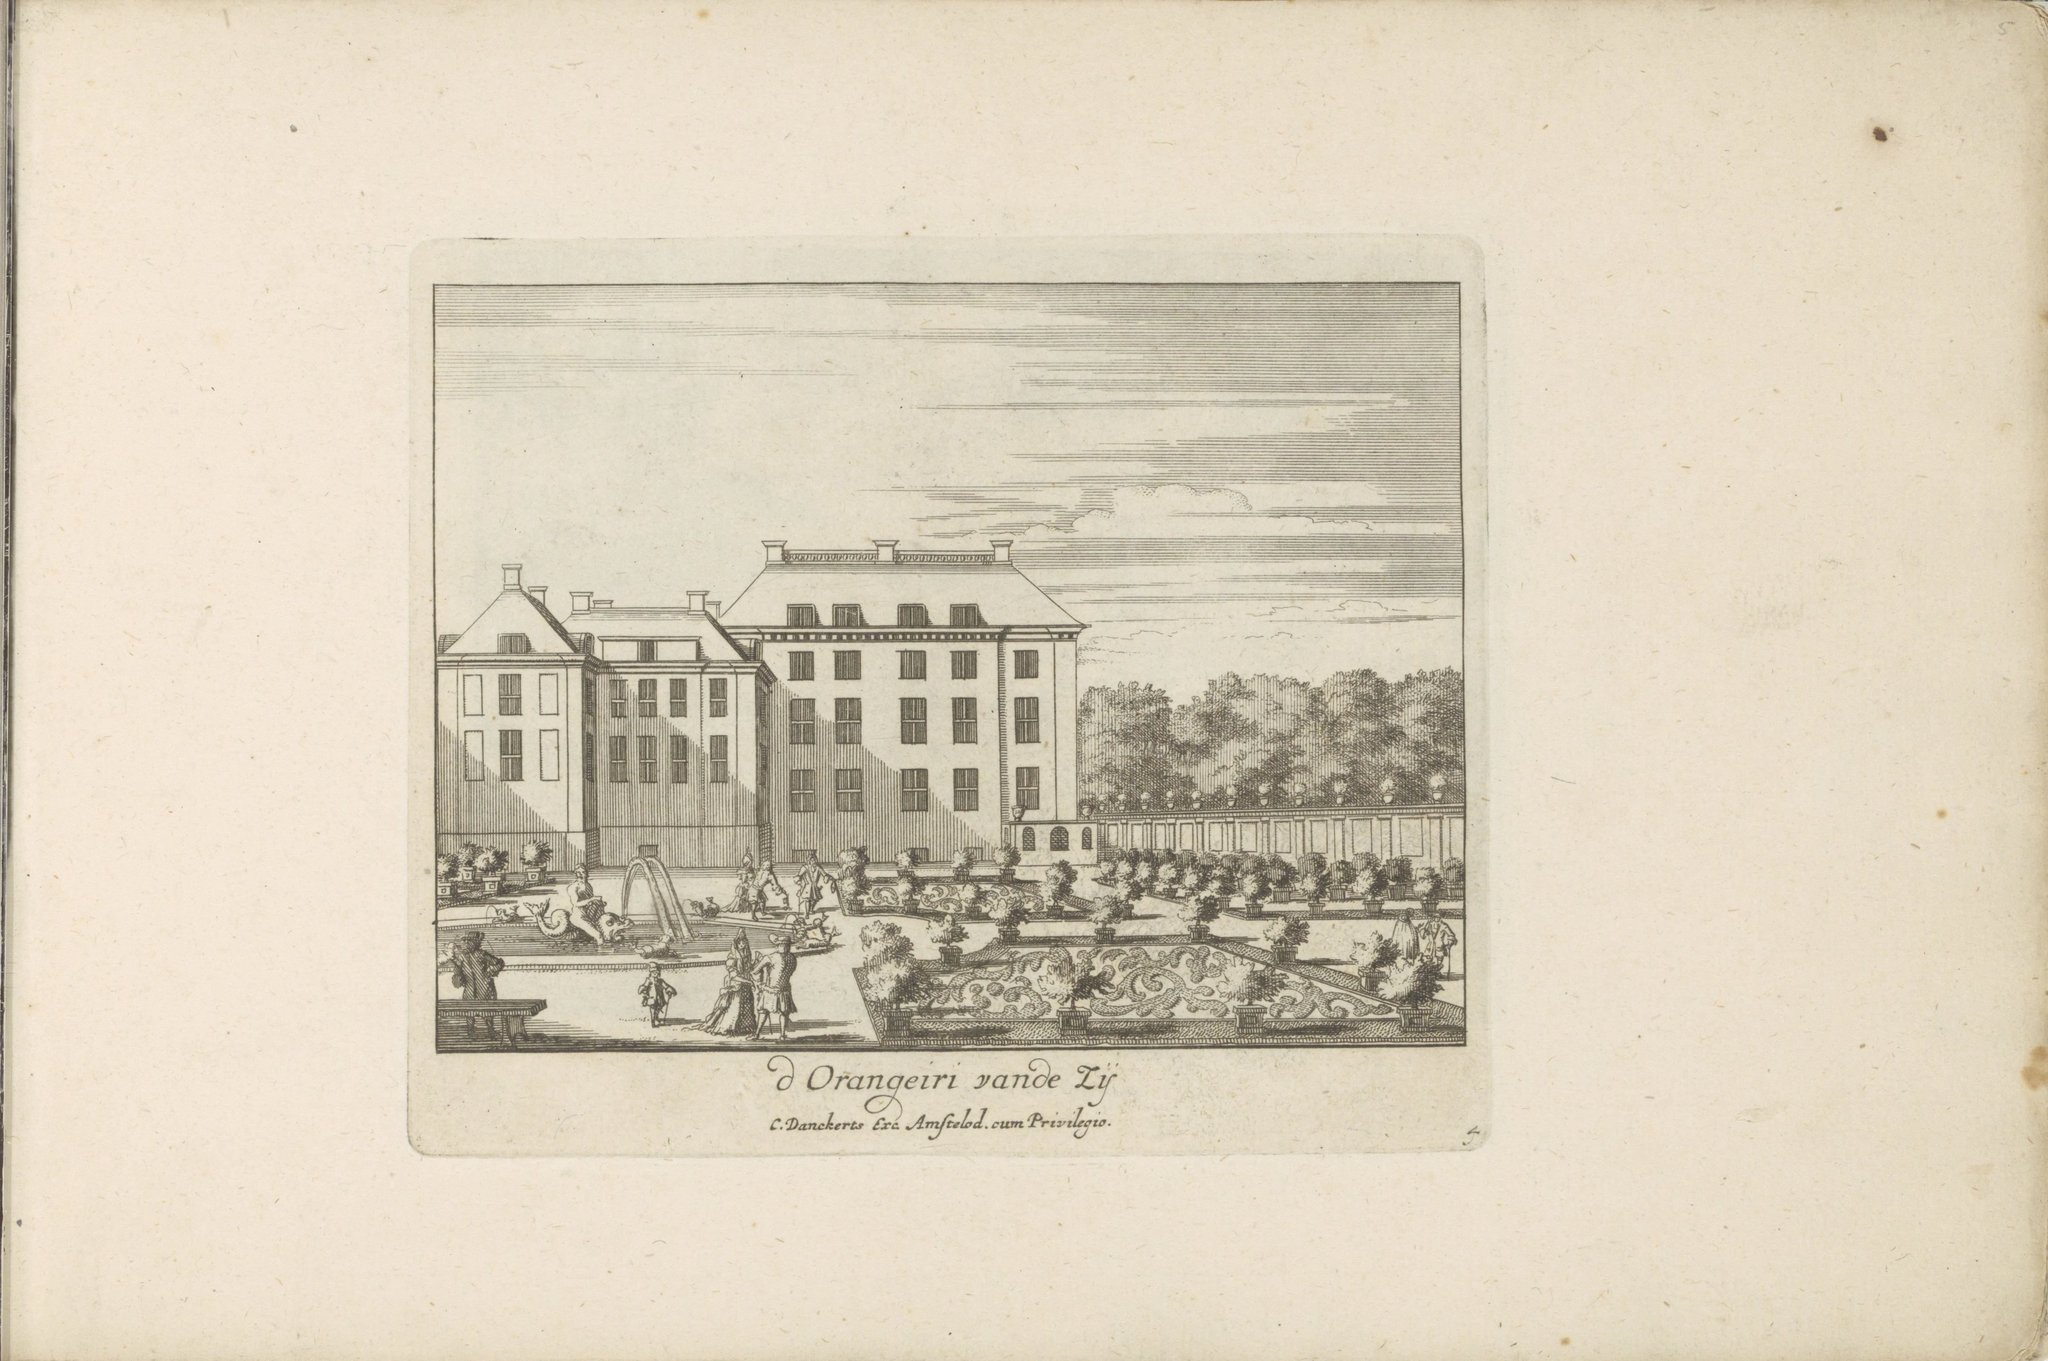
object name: print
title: D Orangeirie vande Zij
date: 1696-1718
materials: paper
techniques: etching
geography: amsterdam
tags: palace, french or architectonic garden; formal garden, exterior ~ representation of a building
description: Zijaanzicht van Paleis Het Loo aan de kant van de orangerie. Prent maakt deel uit van een album.